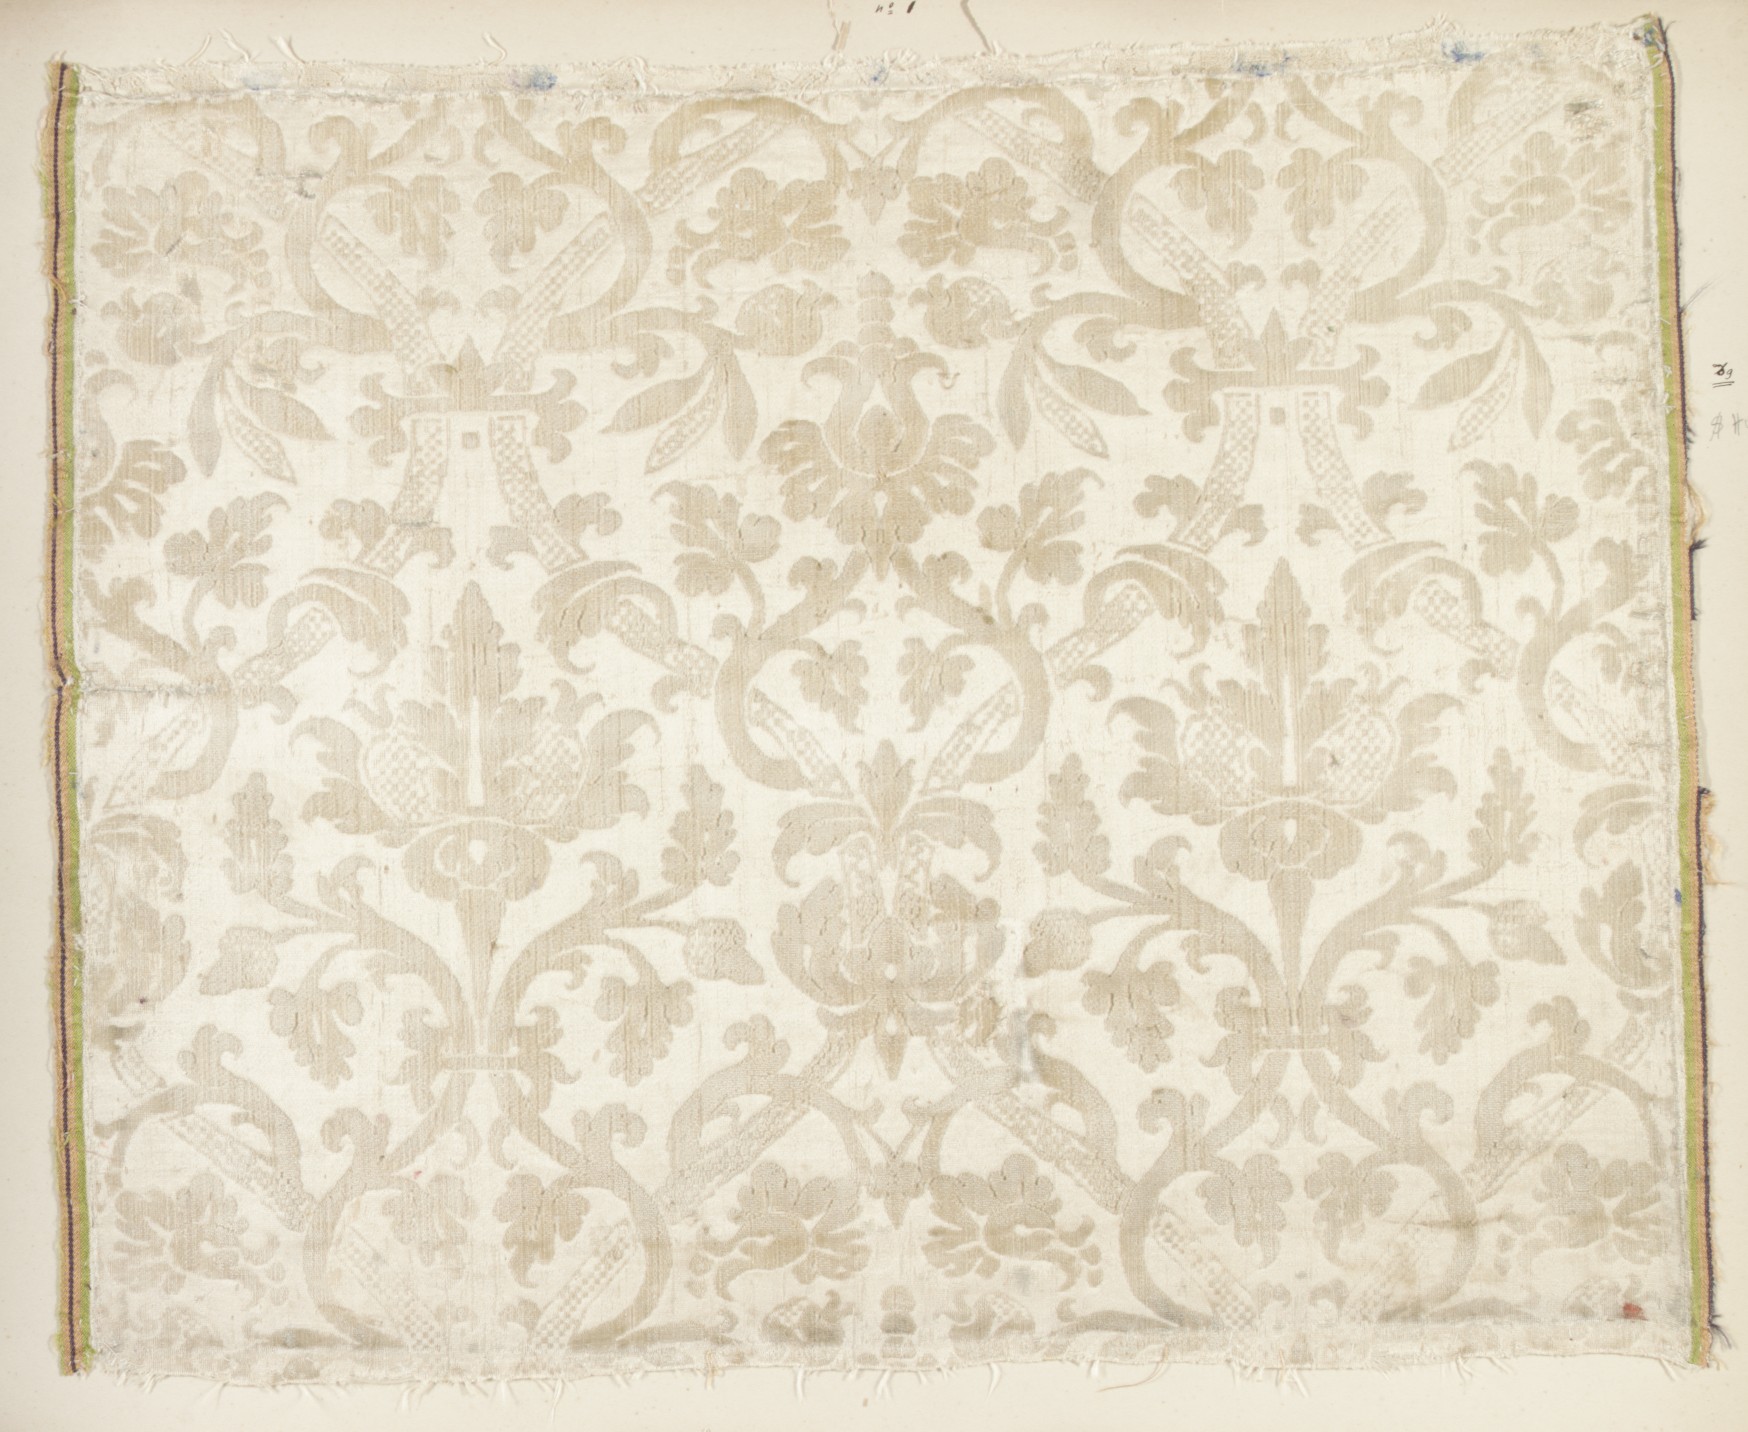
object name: fragment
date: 1601-1700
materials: silk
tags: flowers,leaves